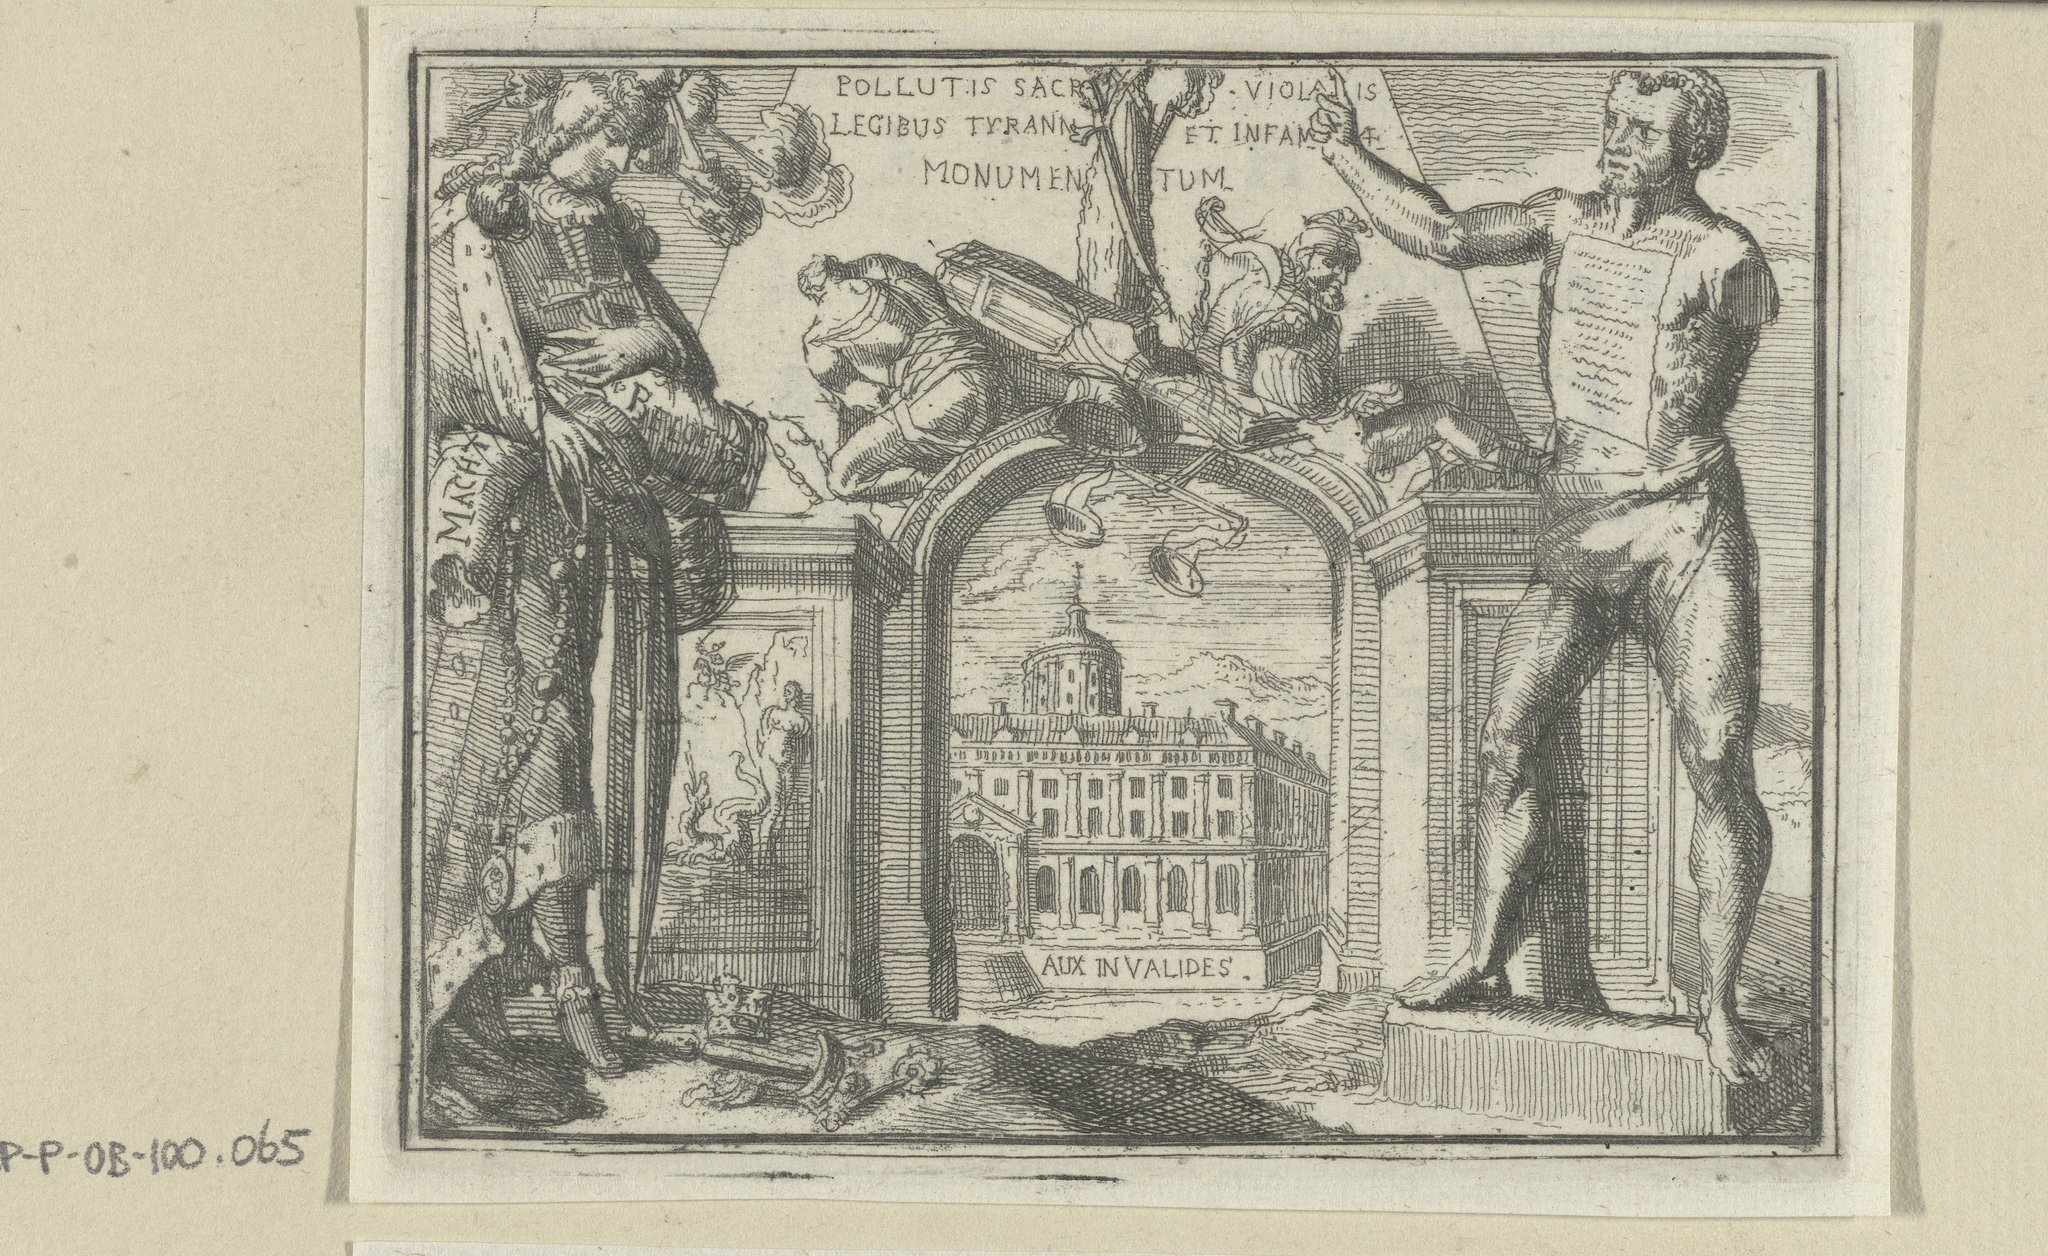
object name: print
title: Titelblad voor het pamflet: Grafschrift door Marforio over een der Vaders van Jaquet Bandyt, 1701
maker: romeyn de hooghe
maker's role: draughtsman, goldsmith, painter, print maker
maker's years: 1645-1708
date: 1701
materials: paper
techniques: etching, letterpress printing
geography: netherlands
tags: jacobus ii (koning van engeland en schotland), london, rome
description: Spotprent op het overlijden van Jacobus II. Marforio gebarend tegen de zoon van Jacobus II (het molenaarskind), tussen en in een monument met een doorkijk naar het Hôtel des Invalides te Parijs. Titel staat op apart tekstblad.